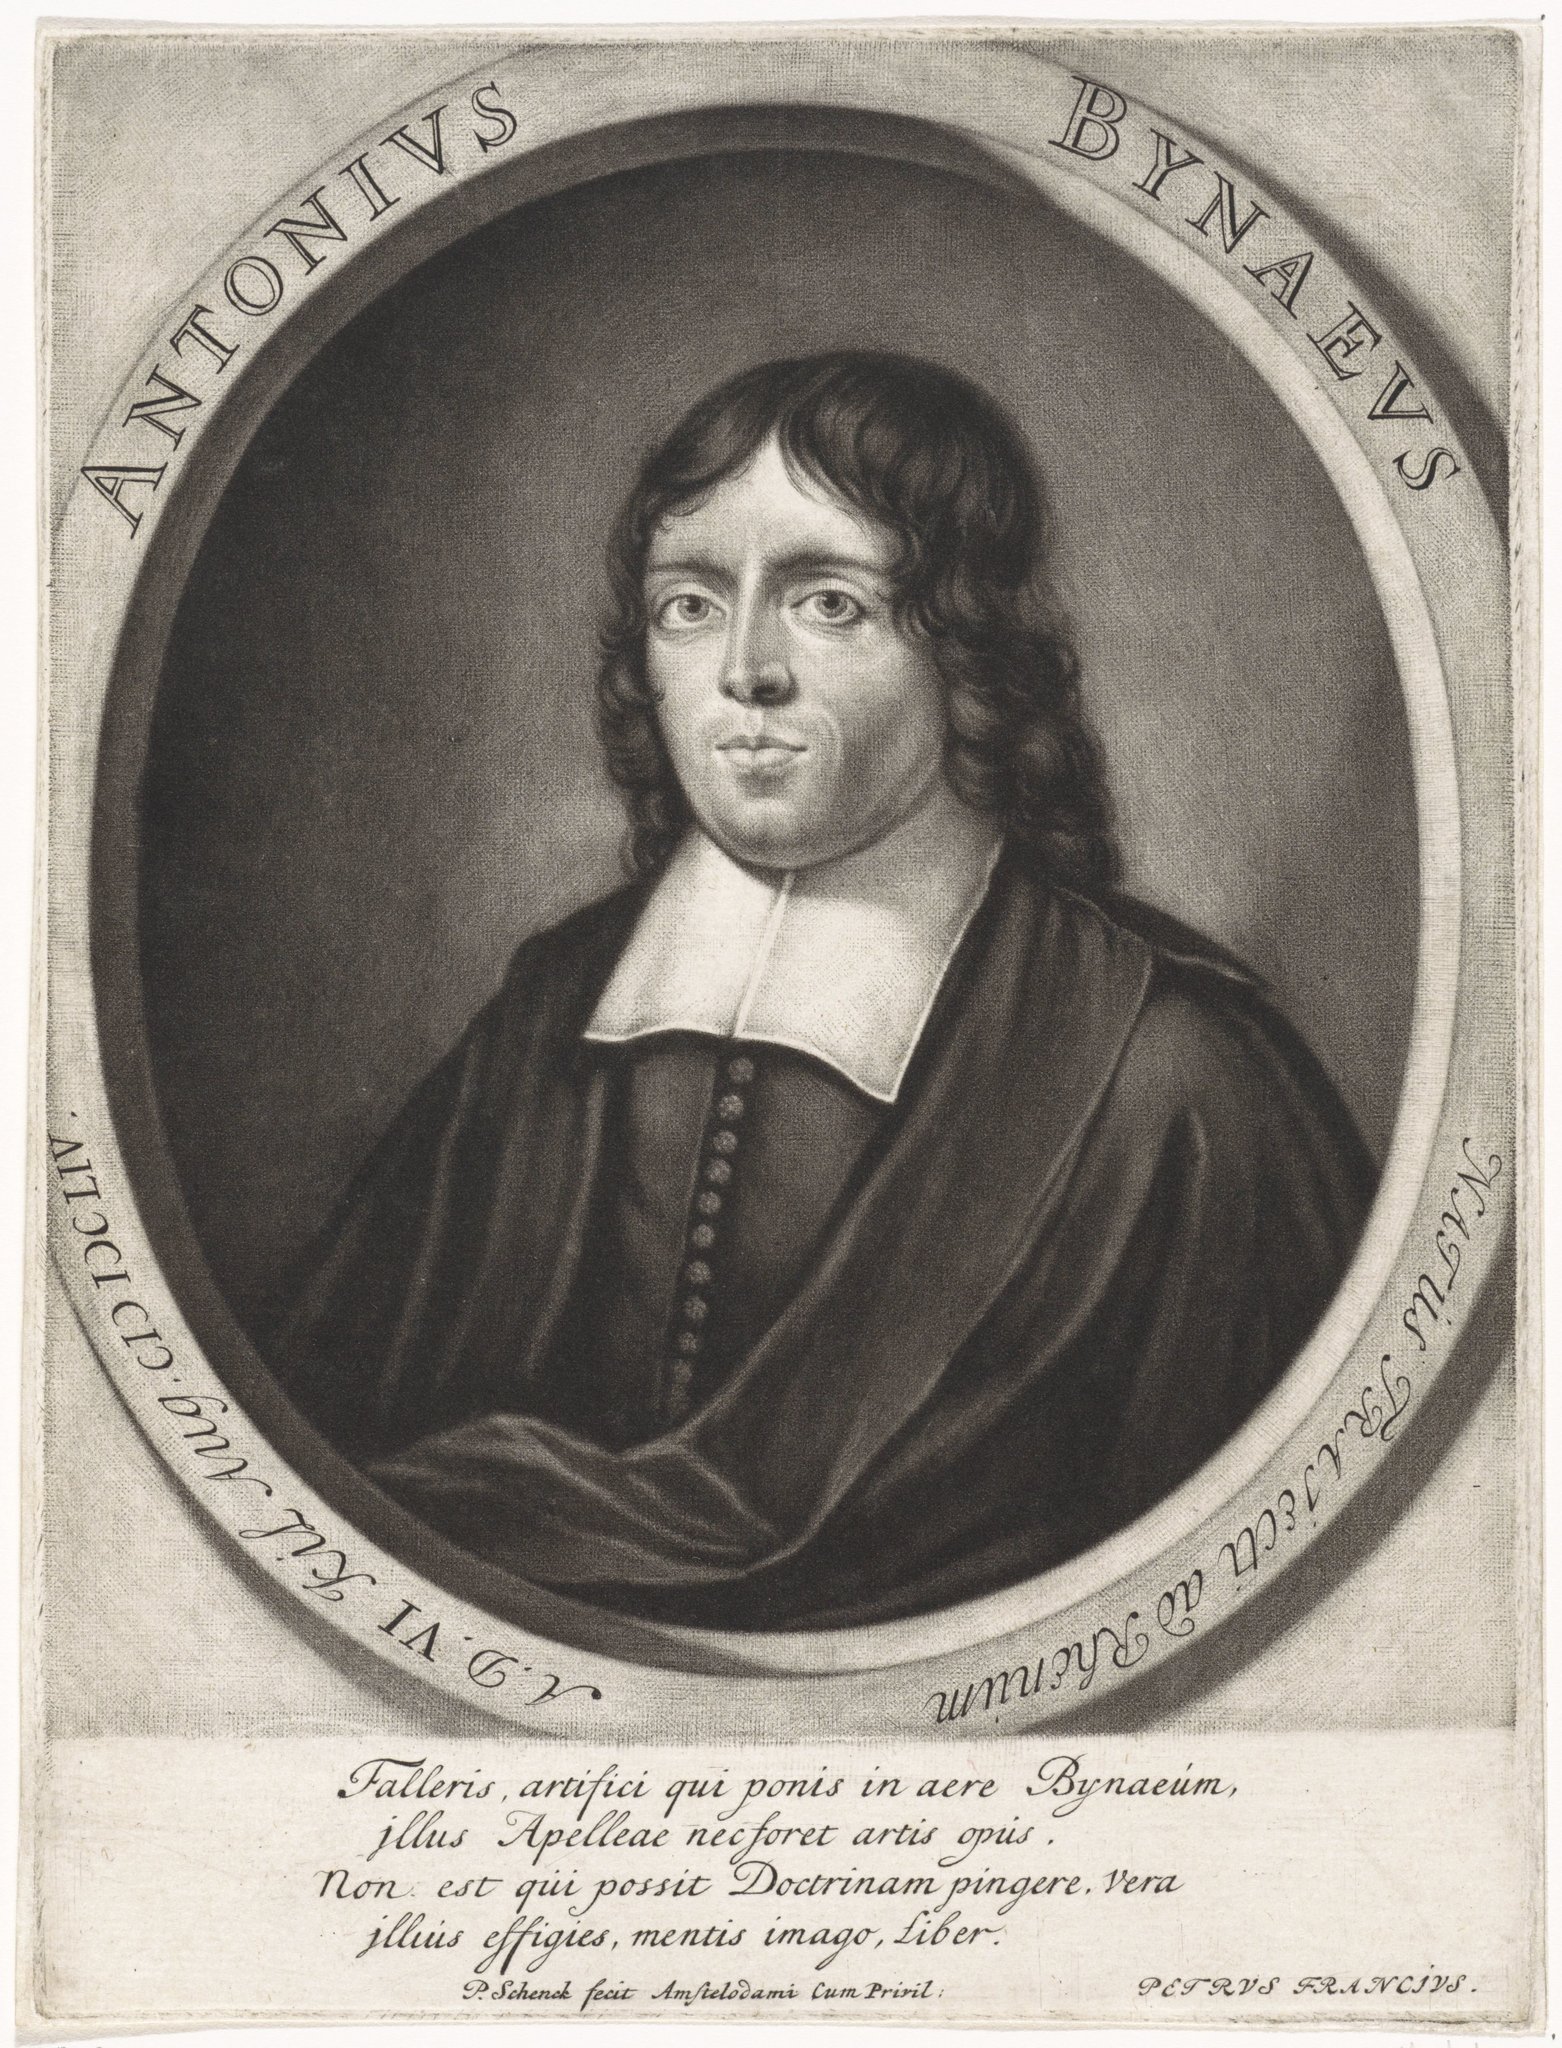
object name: print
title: Portret van de predikant Anton Bynaeus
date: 1670-1713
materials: paper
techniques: engraving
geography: amsterdam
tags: theologian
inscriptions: collector's mark: Lugt 2228